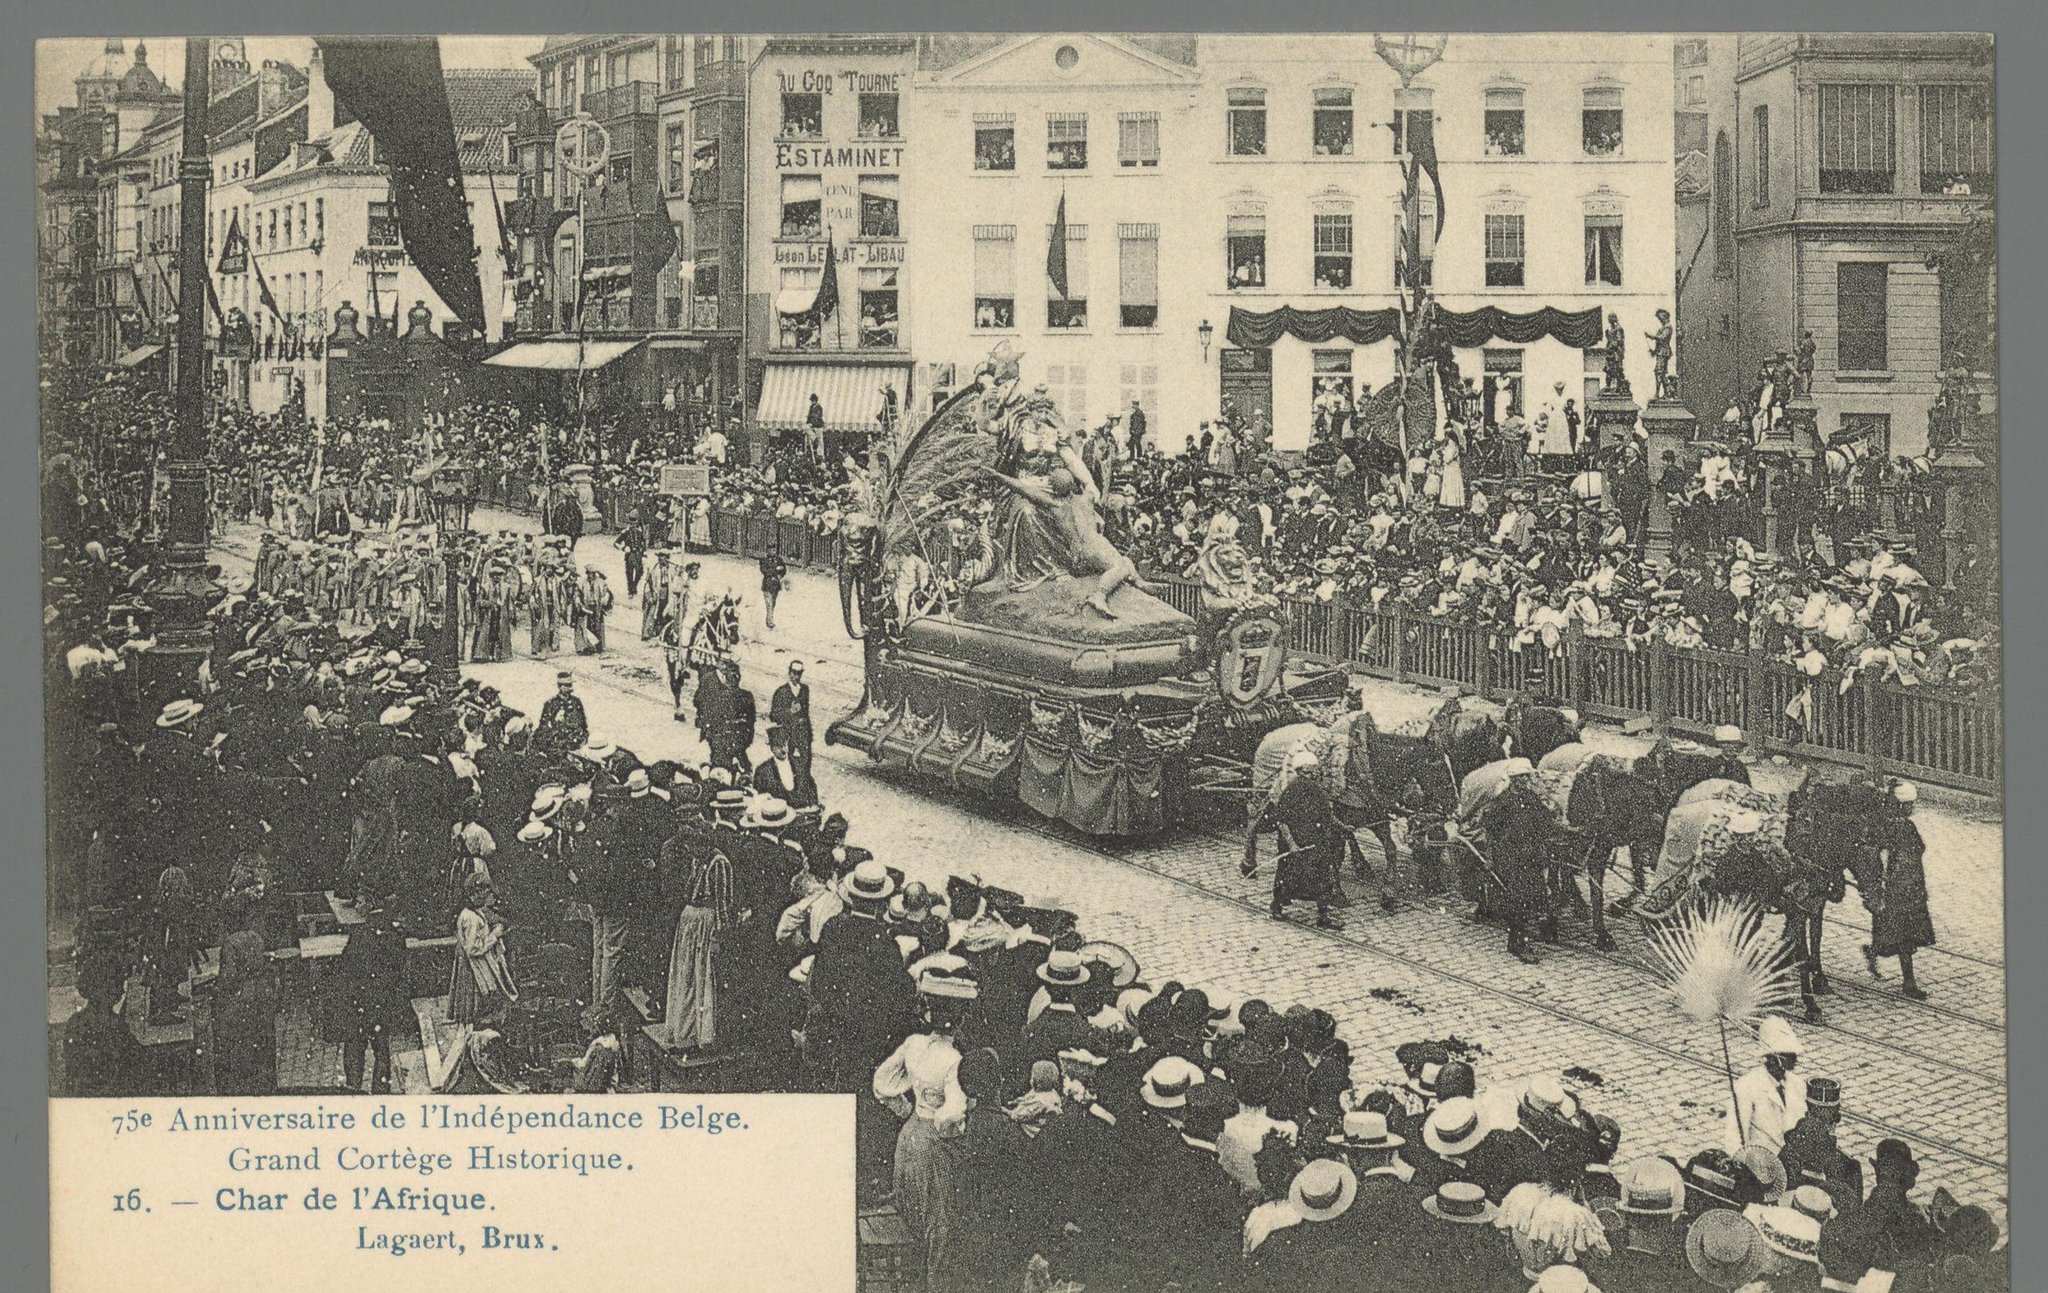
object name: photomechanical print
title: 75e Anniversaire de l'Indépendance Belge. Grand Cortège Historique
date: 1905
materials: cardboard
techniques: photograph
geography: brussels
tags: city-view, and landscape with man-made constructions (+ city(-scape) with figures, staffage), periodic celebrations, popular feasts, brussels